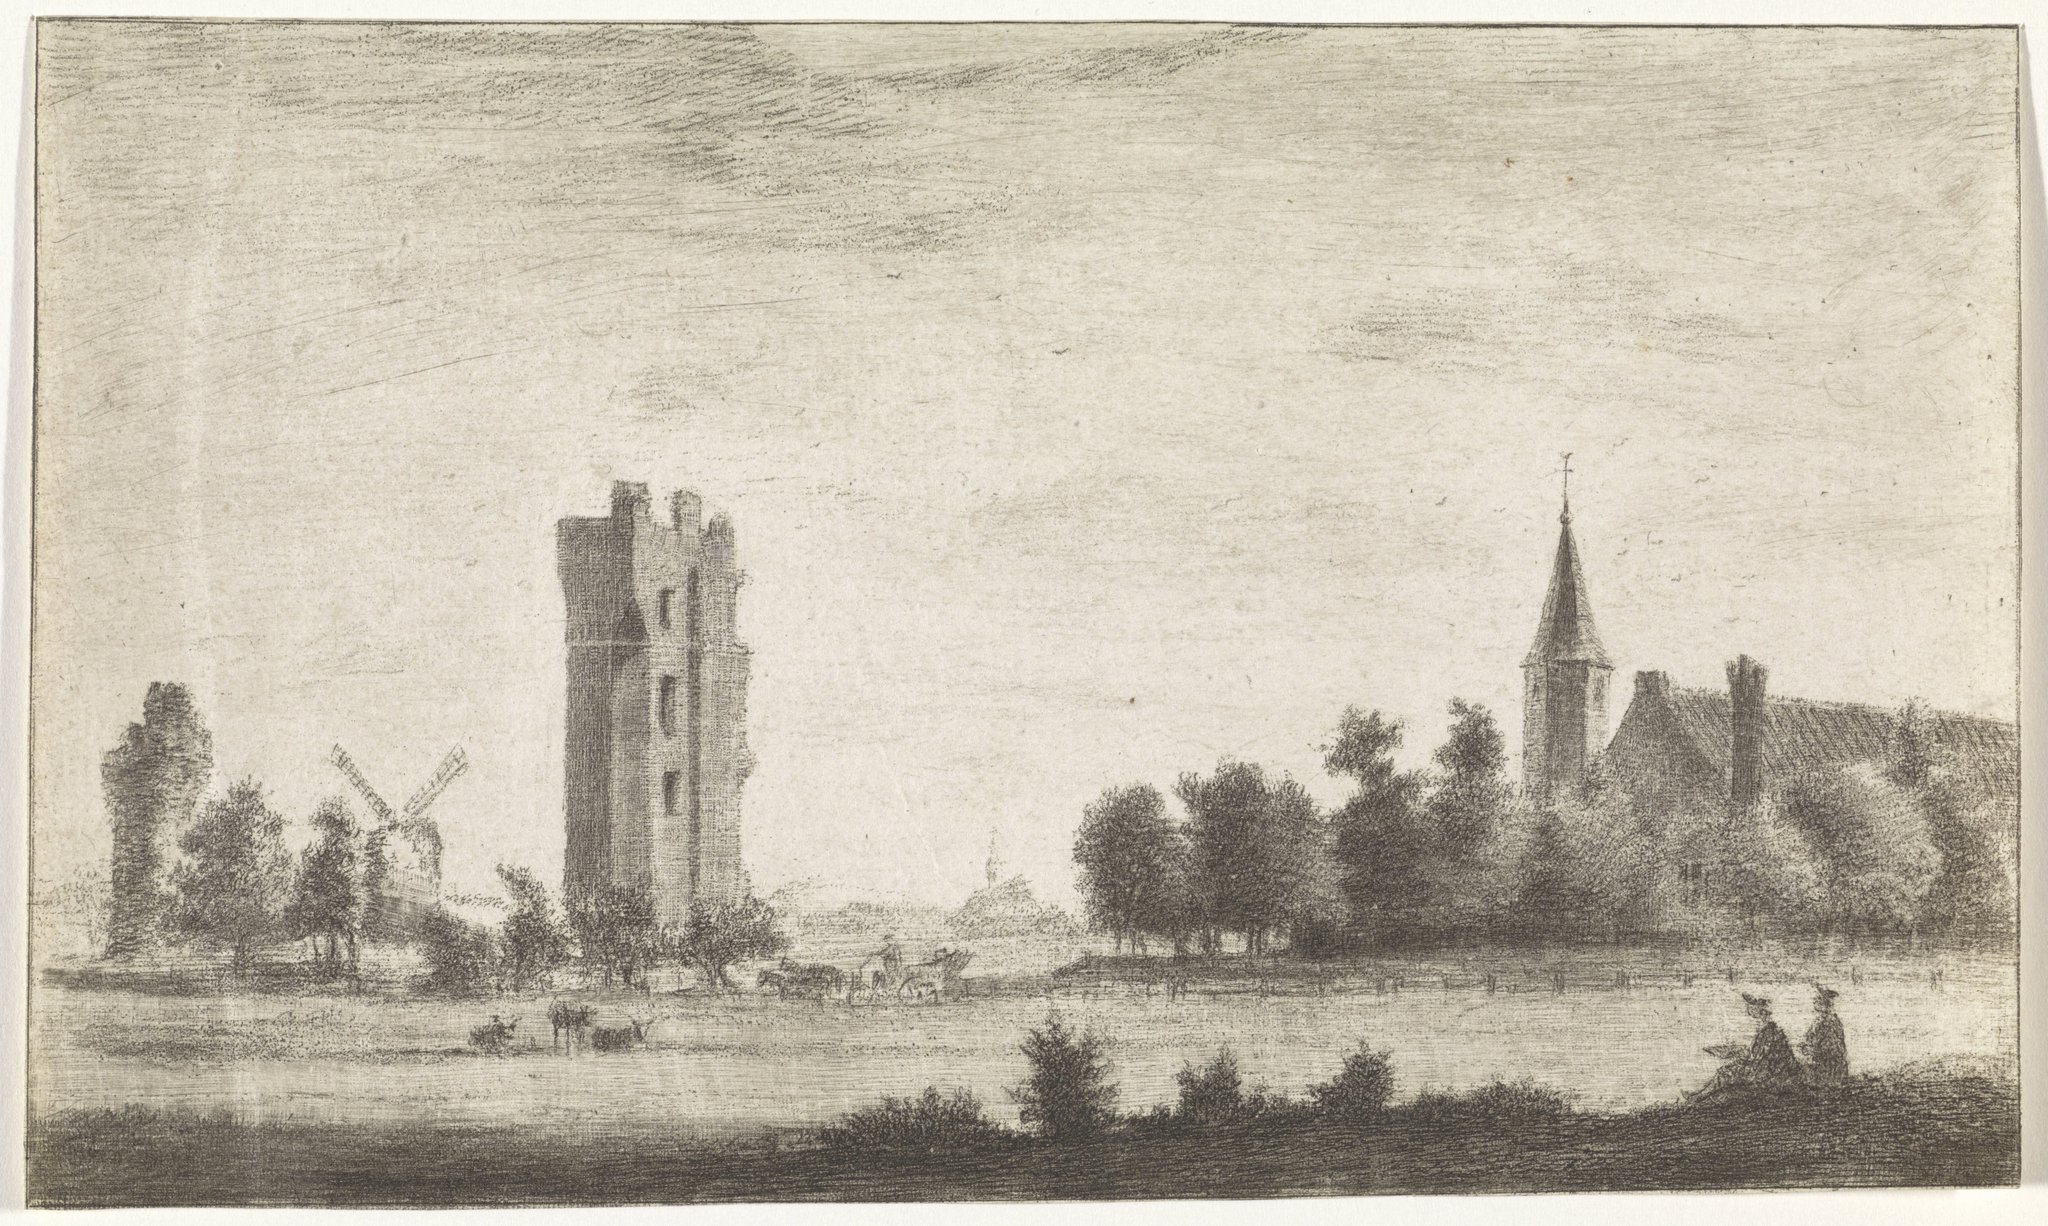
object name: print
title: Landschap met de ruïne Huis ter Kleef en twee tekenaars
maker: hendrik spilman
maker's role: draughtsman, painter, print maker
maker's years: 1721-1784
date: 1742-1784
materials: paper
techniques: etching, roulette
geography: haarlem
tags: drawing (+ artist at work), church (exterior), landscape with ruins, landscape with tower or castle, ruin of a dwelling, house, castle, etc.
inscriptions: collector's mark: Lugt 2228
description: Landschap met de ruïne van het Huis ter Kleef te Haarlem, met links een molen en rechts een kerk. In een weiland graast vee en op de voorgrond zitten twee tekenaars.